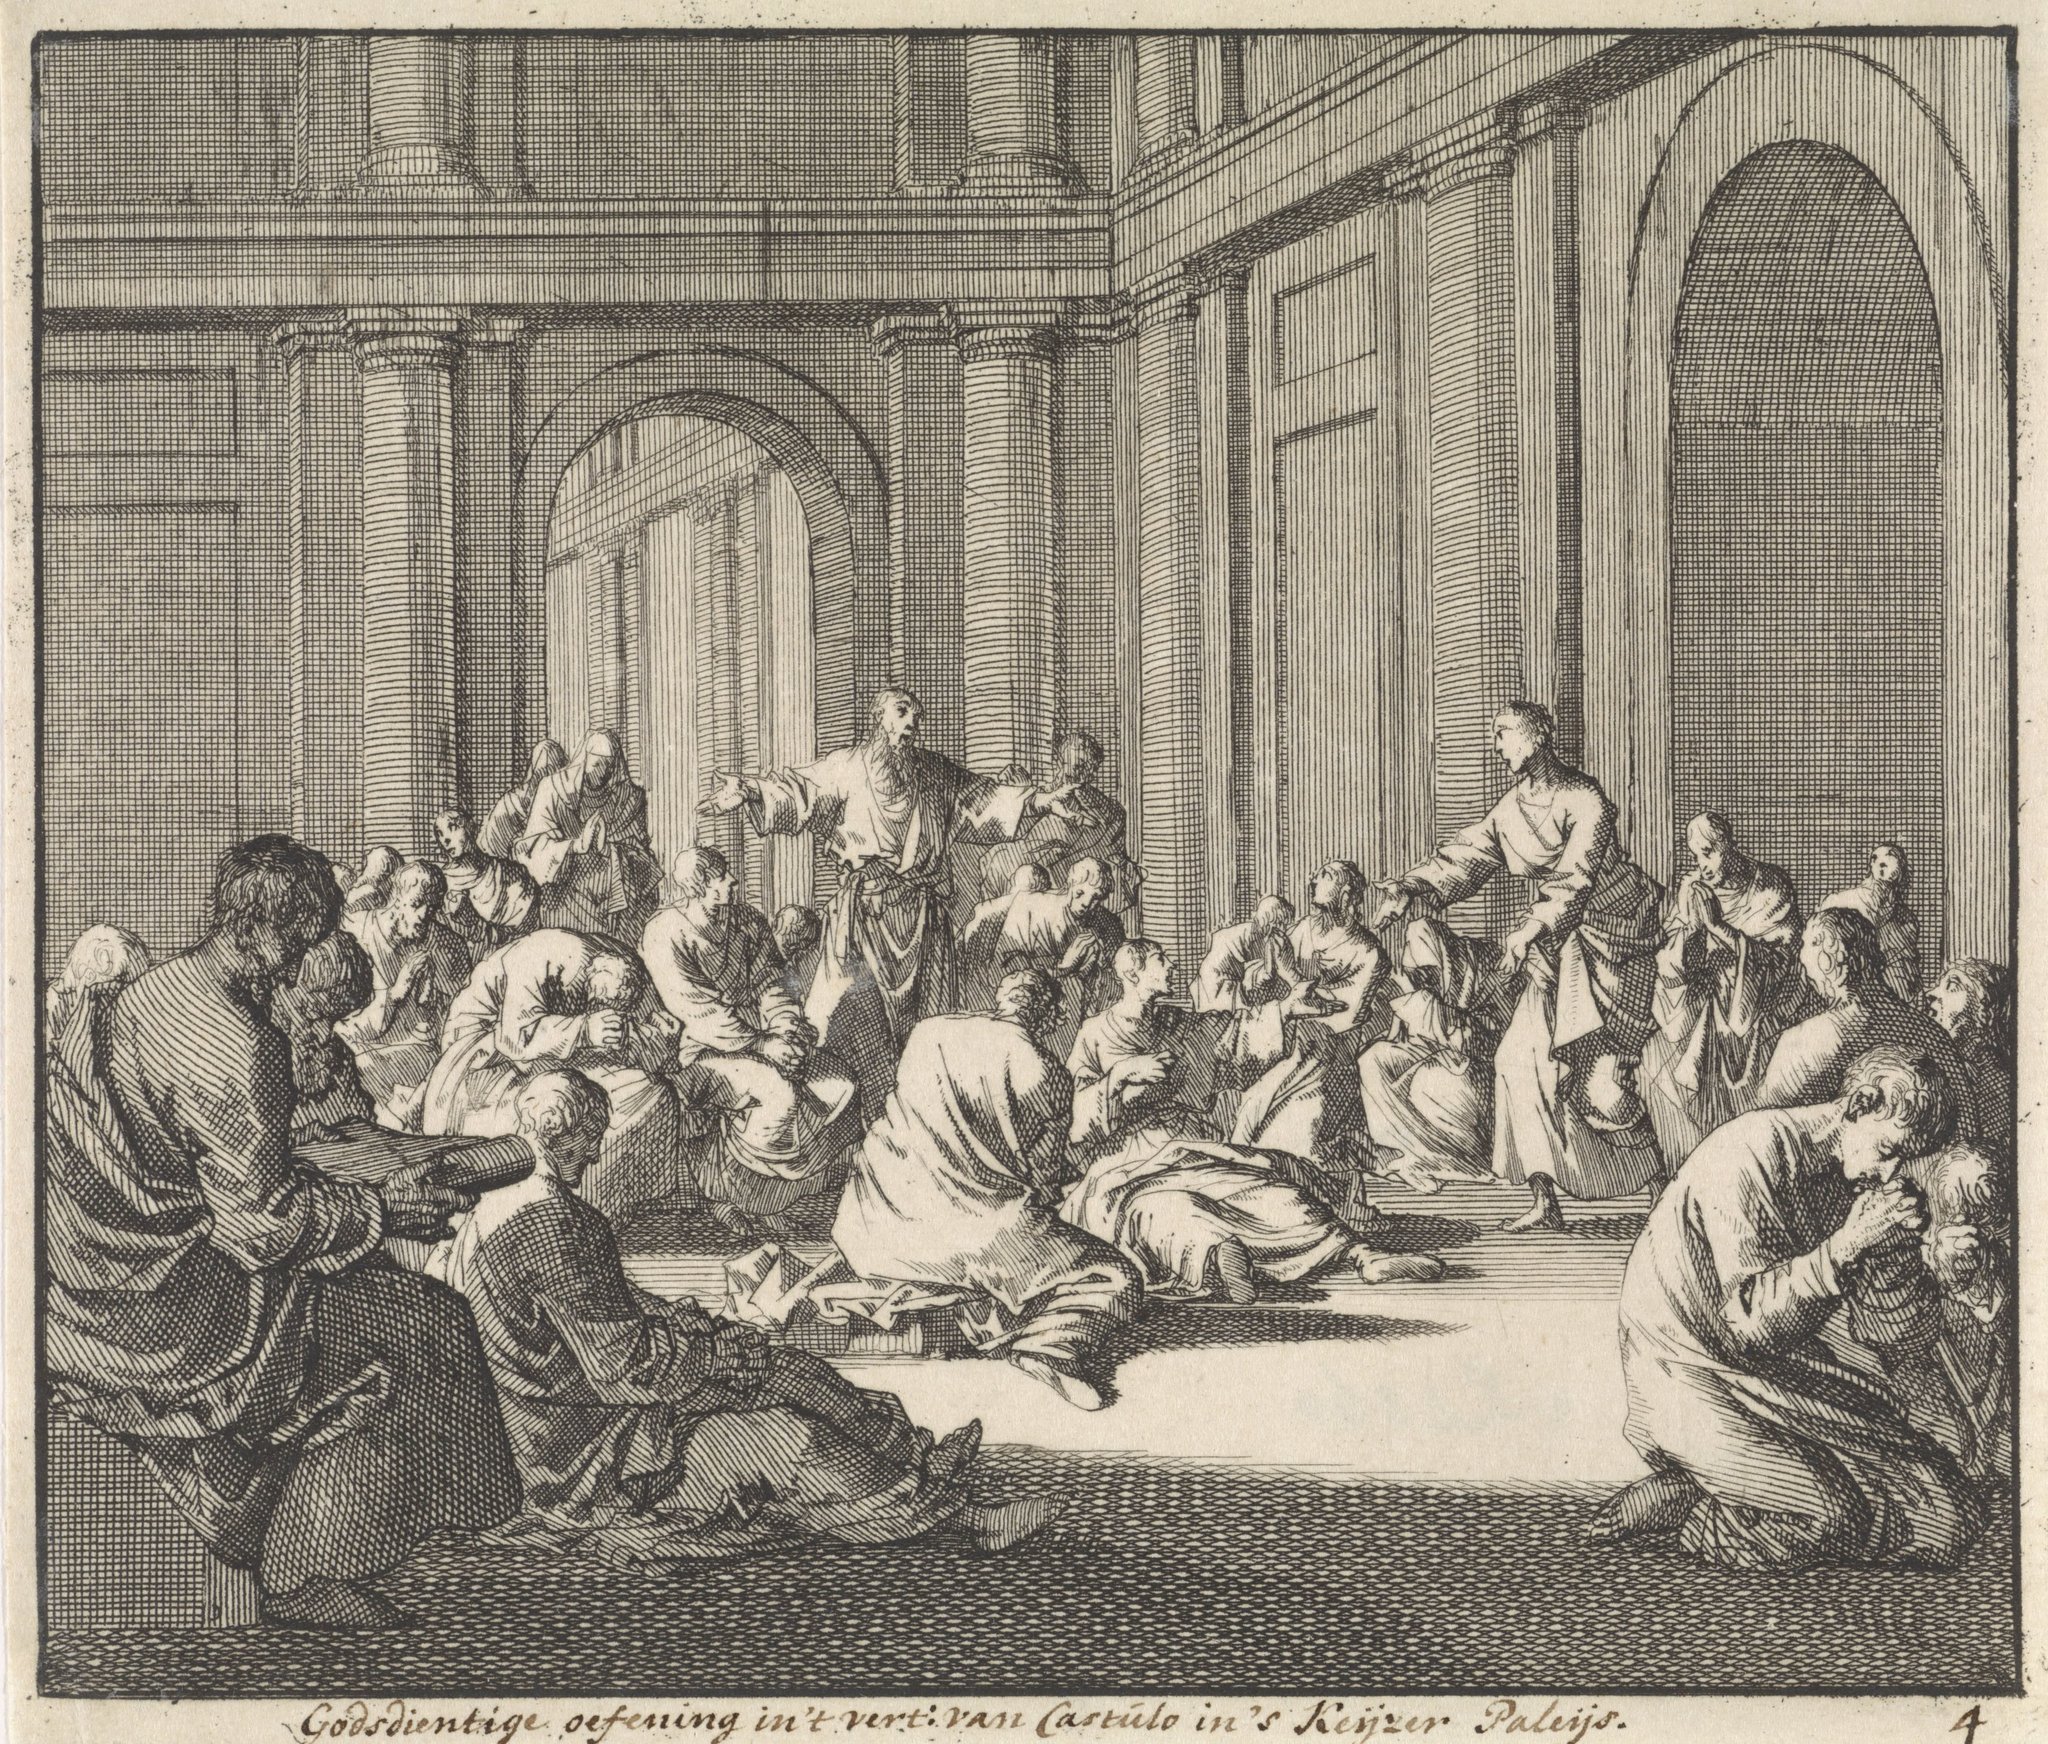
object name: print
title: Samenkomst van Christenen in de kamer van de heilige Castulus in het keizerlijk paleis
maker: jan luyken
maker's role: draughtsman, print maker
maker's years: 1649-1712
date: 1700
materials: paper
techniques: etching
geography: amsterdam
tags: the early christian churches, e.g. armenians, copts, syrians, palace, male saints (with name), meeting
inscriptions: number: ‘4’, collector's mark: Lugt 2228, caption: ‘Godsdienstige oefening in 't vertrek van Castulo in's Keyzer Paleys’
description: Proefdruk van een boekillustratie voor Arnold, Godfried. Waare afbeelding der eerste christenen. Amsterdam: Jacobus van Hardenberg, Barent Visscher en Jacobus van Nieuweveen, 1700, dl. 1.